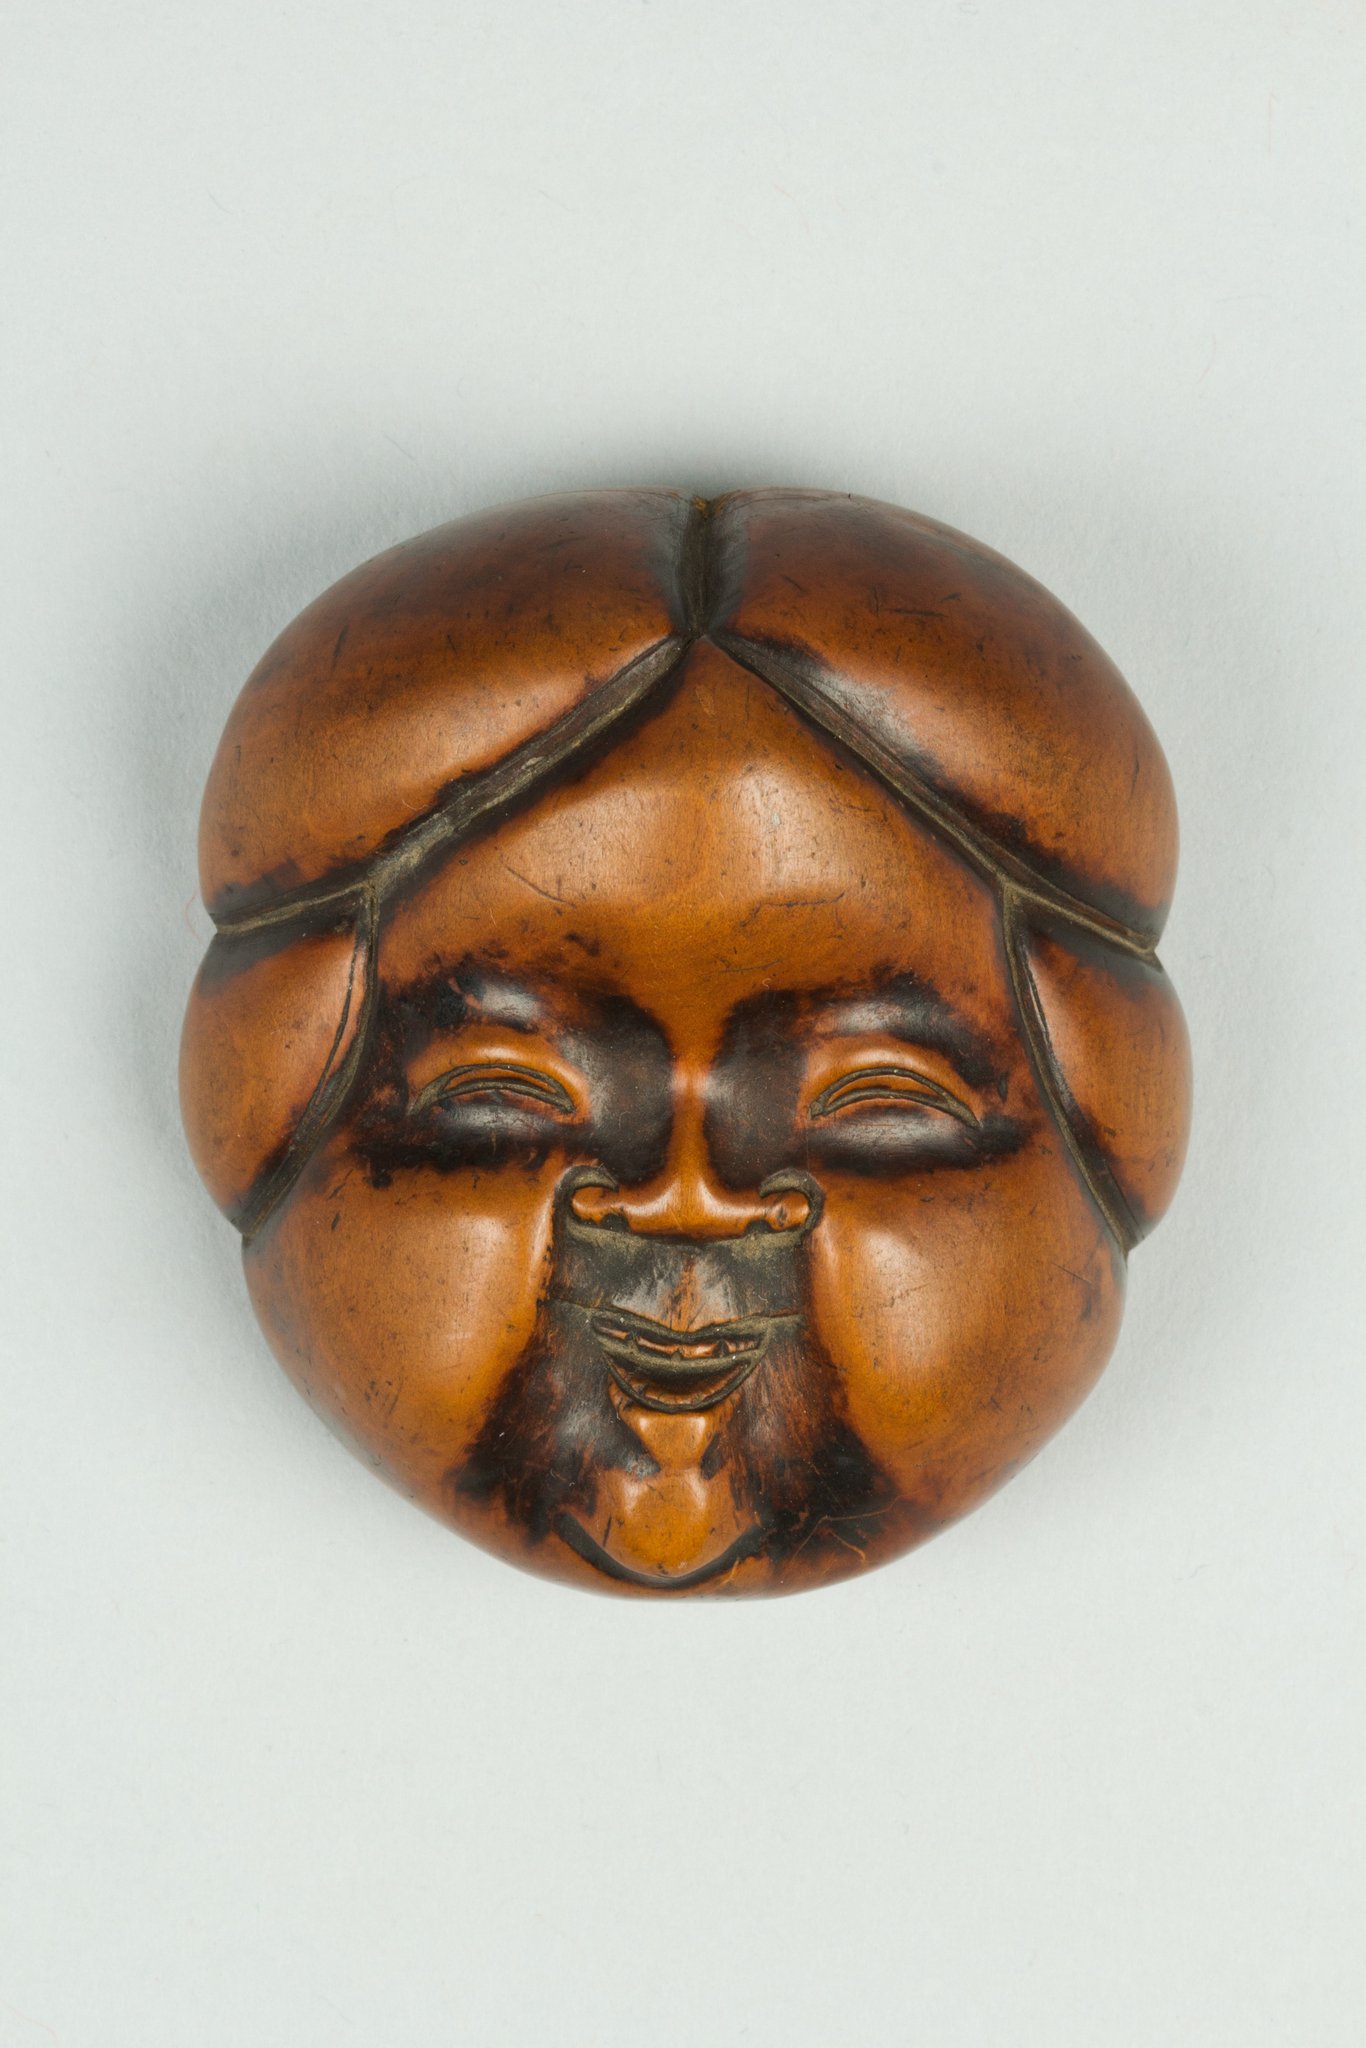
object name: netsuke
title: Netsuke of Noh Mask; Face of Usume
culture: japanese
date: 1701-1800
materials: wood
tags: masks